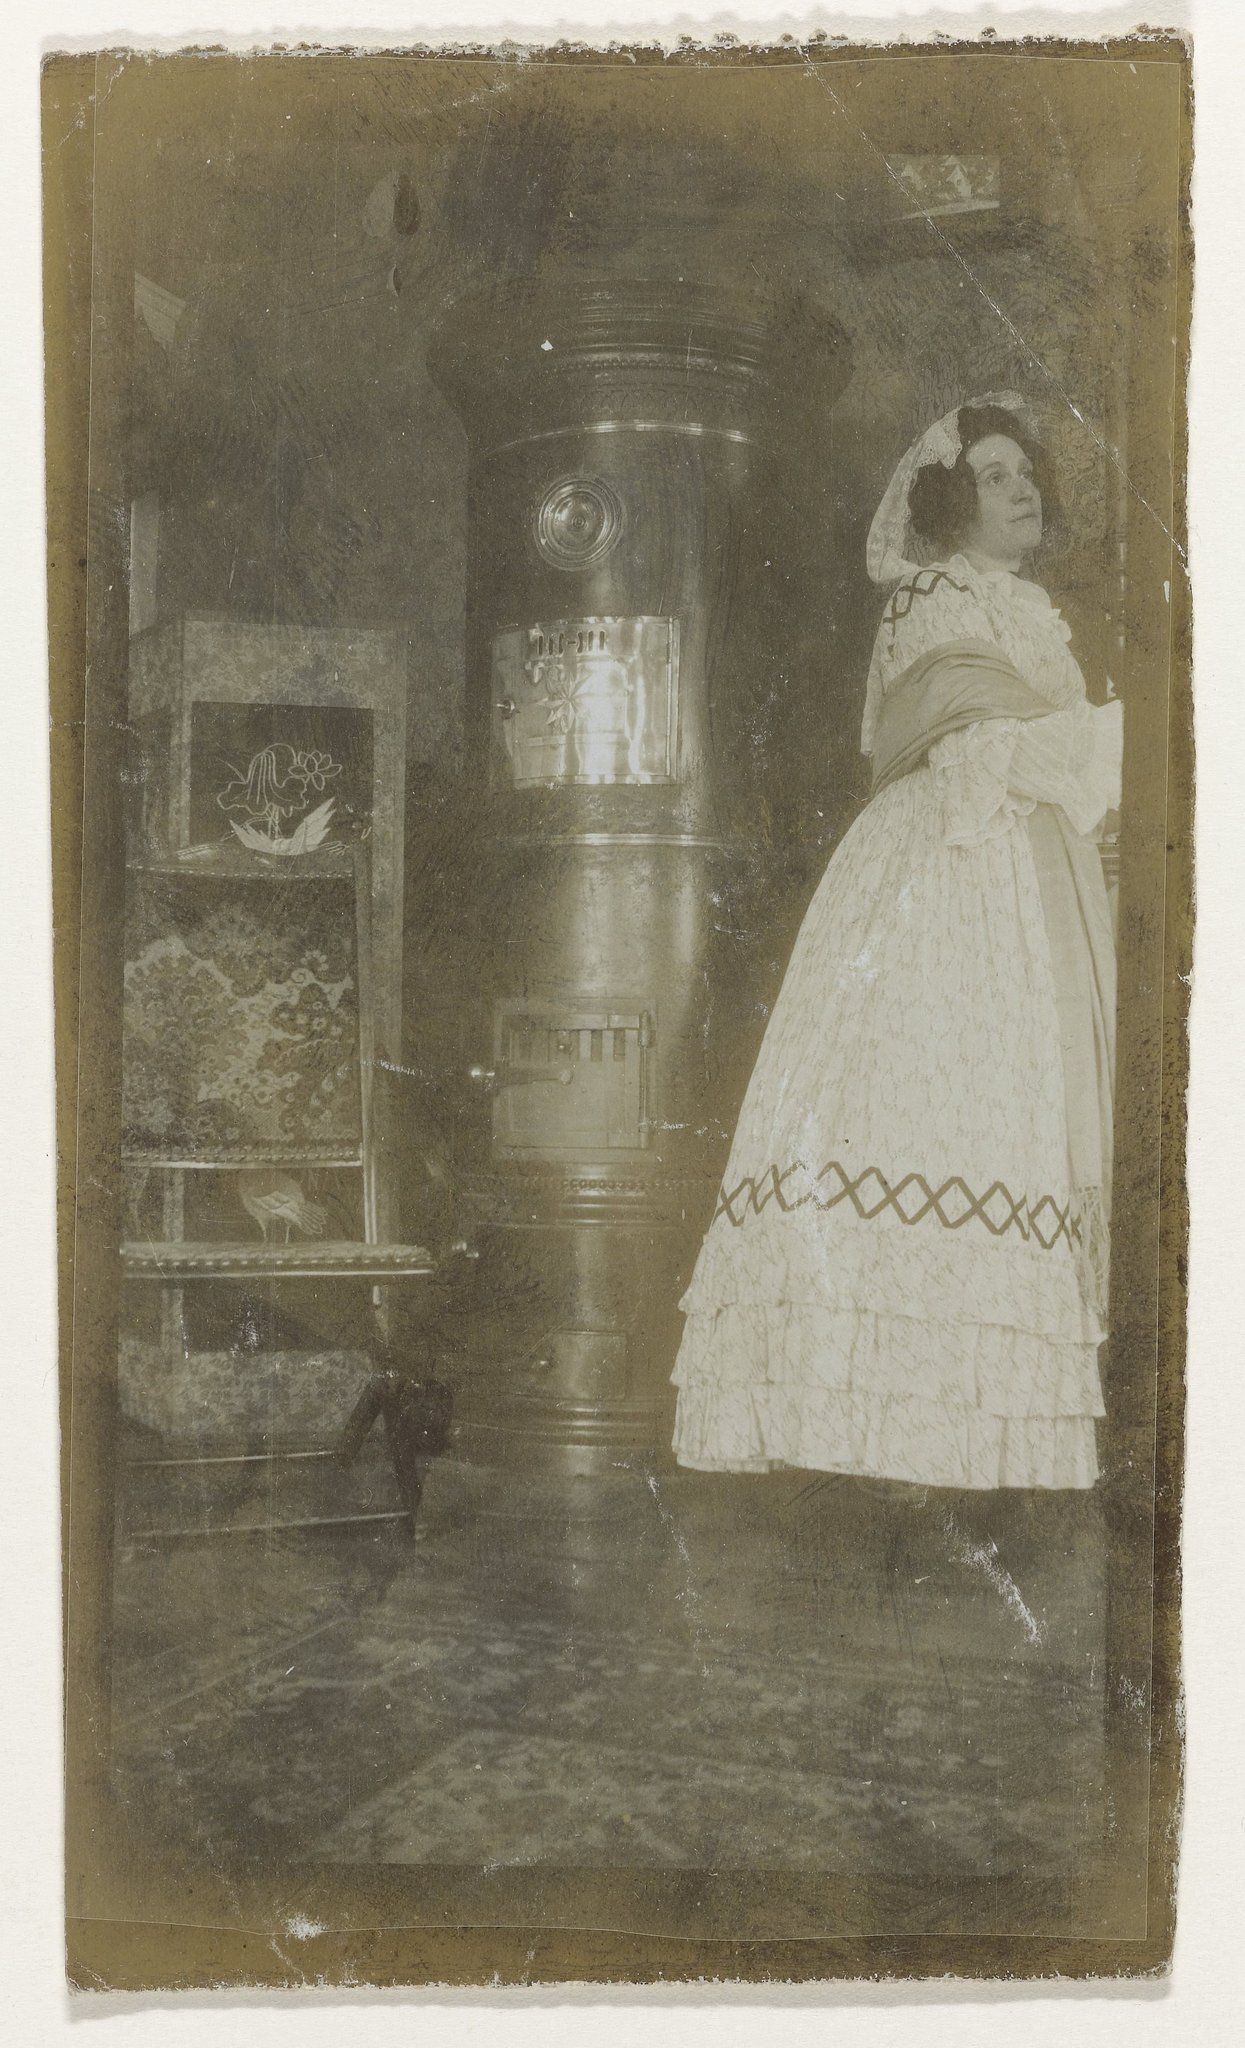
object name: photograph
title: Vrouw bij kachel in interieur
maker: Anonymous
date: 1900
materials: paper, photographic support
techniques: collodion silver print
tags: interior of the house, heating stove